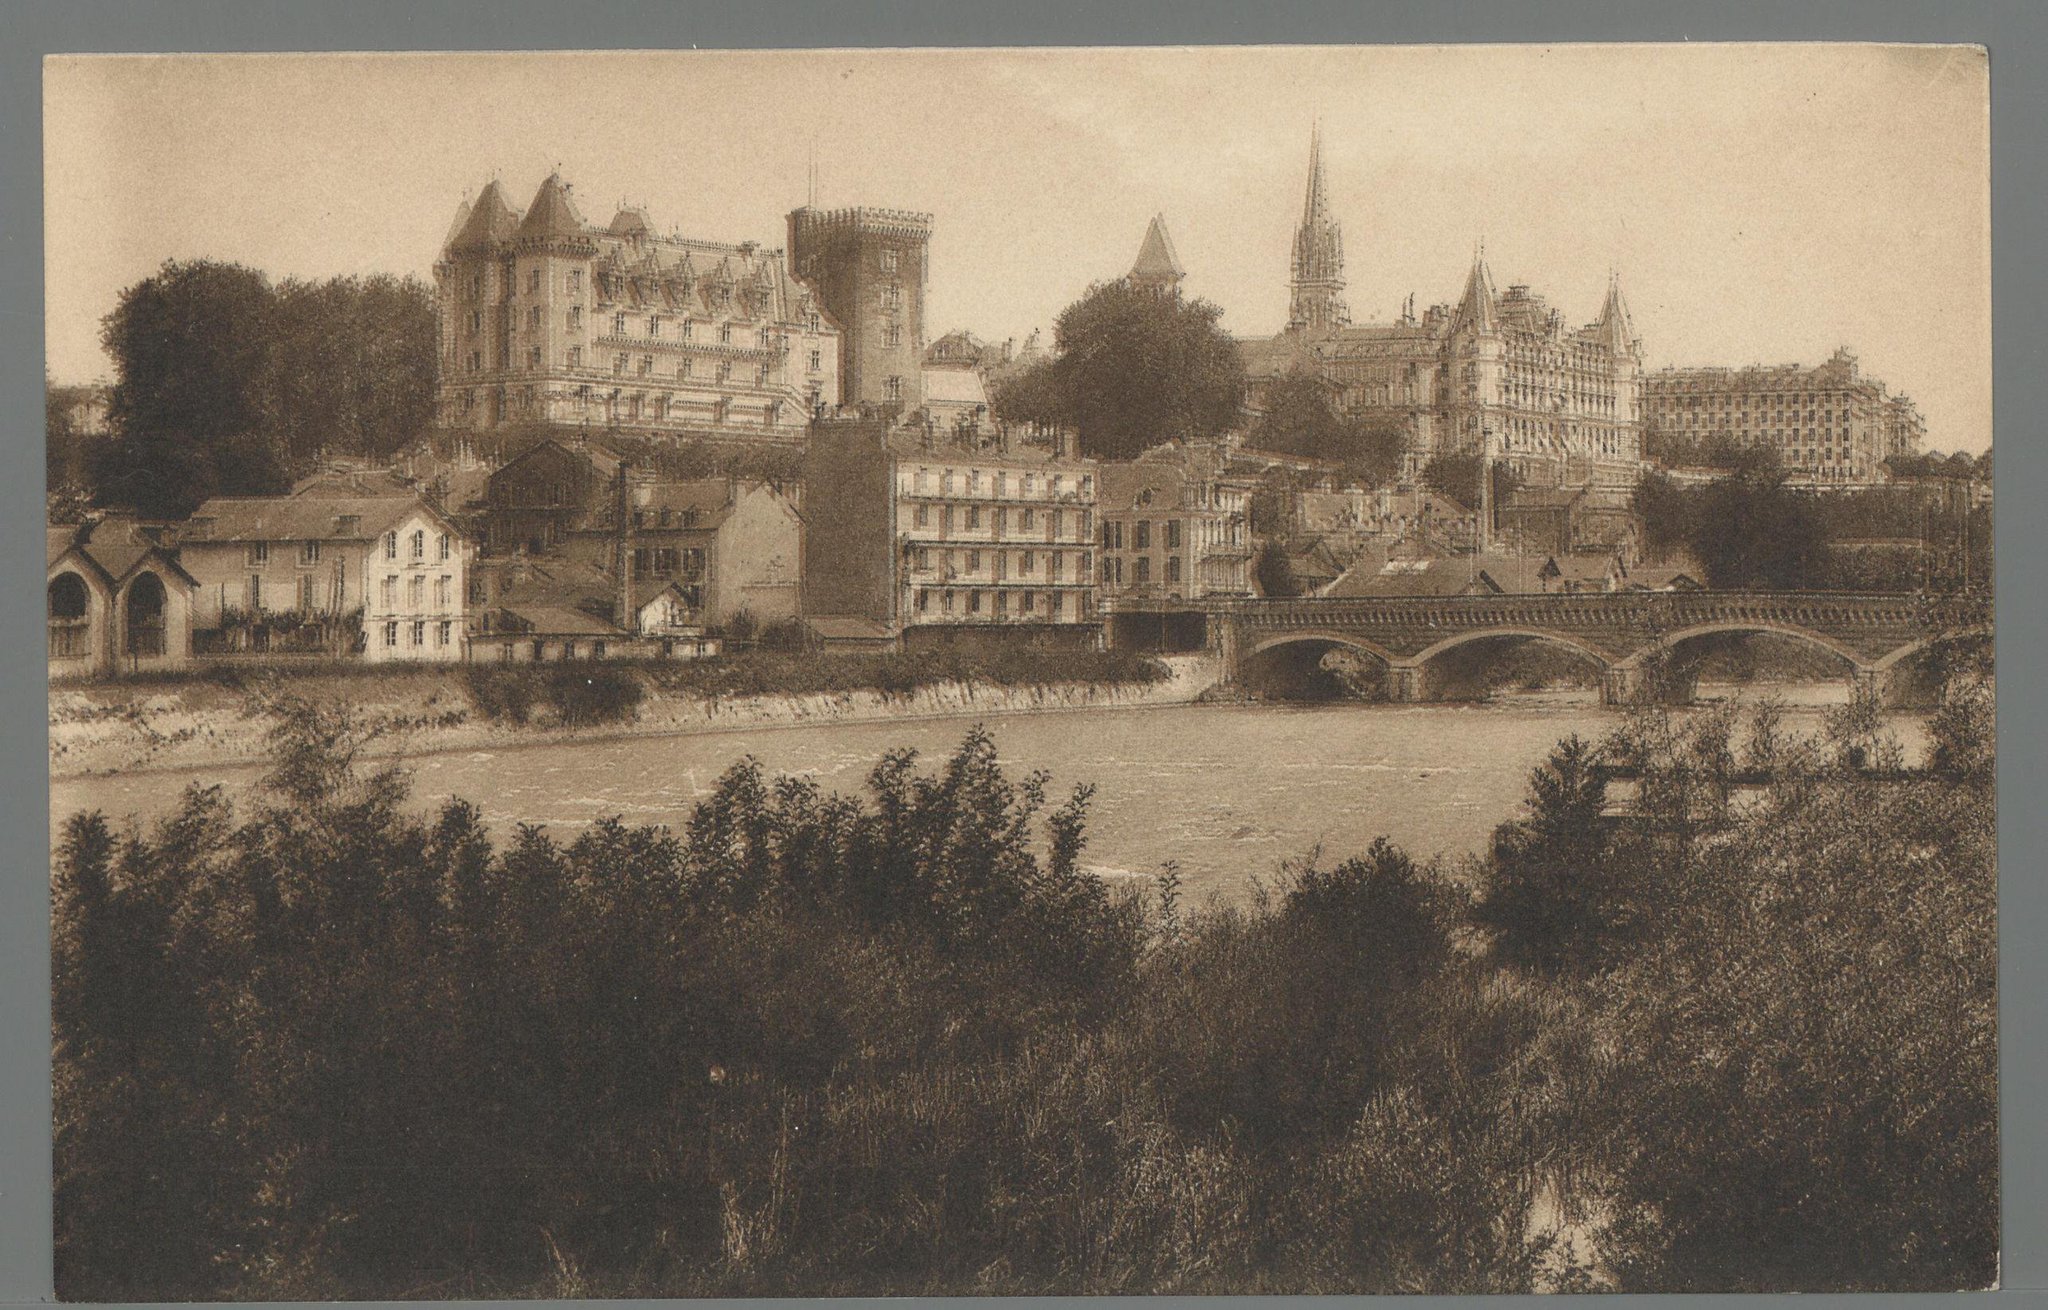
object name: ansichtkaart, prentbriefkaart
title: Pau. Vue prise de Jurançon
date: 1904-1906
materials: cardboard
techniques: photograph, writing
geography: pau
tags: city-view, and landscape with man-made constructions, river, church (exterior)